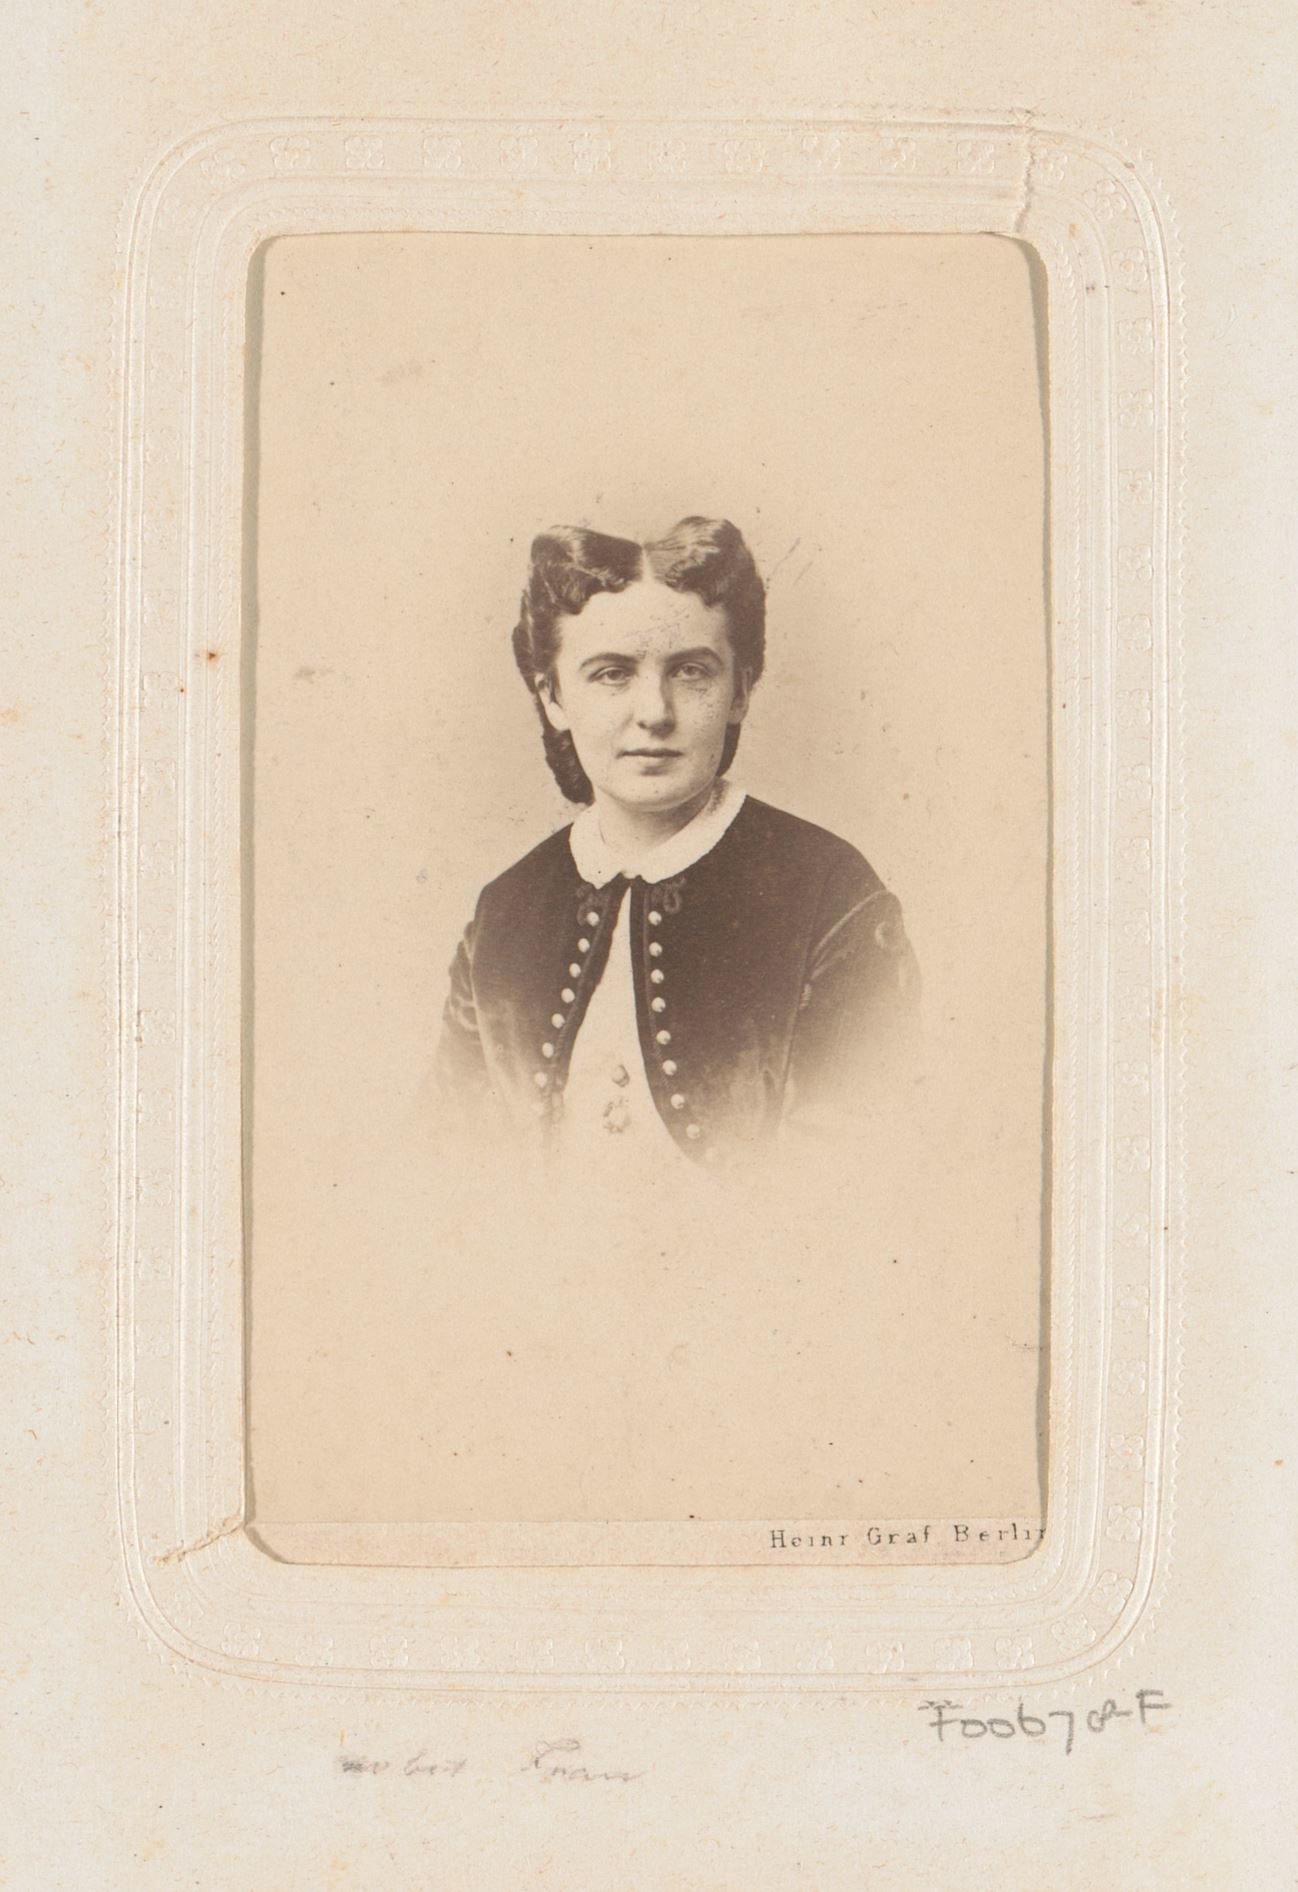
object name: carte de visite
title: Portret van Maria Anna van Anhalt-Dessau, prinses van Pruisen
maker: heinrich graf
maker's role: painter, publisher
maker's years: 1835-1906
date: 1860-1880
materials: cardboard, photographic support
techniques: albumen print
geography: berlin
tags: historical persons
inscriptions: annotation: ‘[...]’, annotation: ‘M’, inscription: ‘Photografie Heinrich Graf/ 165 Friedrichs-Str 165/ Berlin’